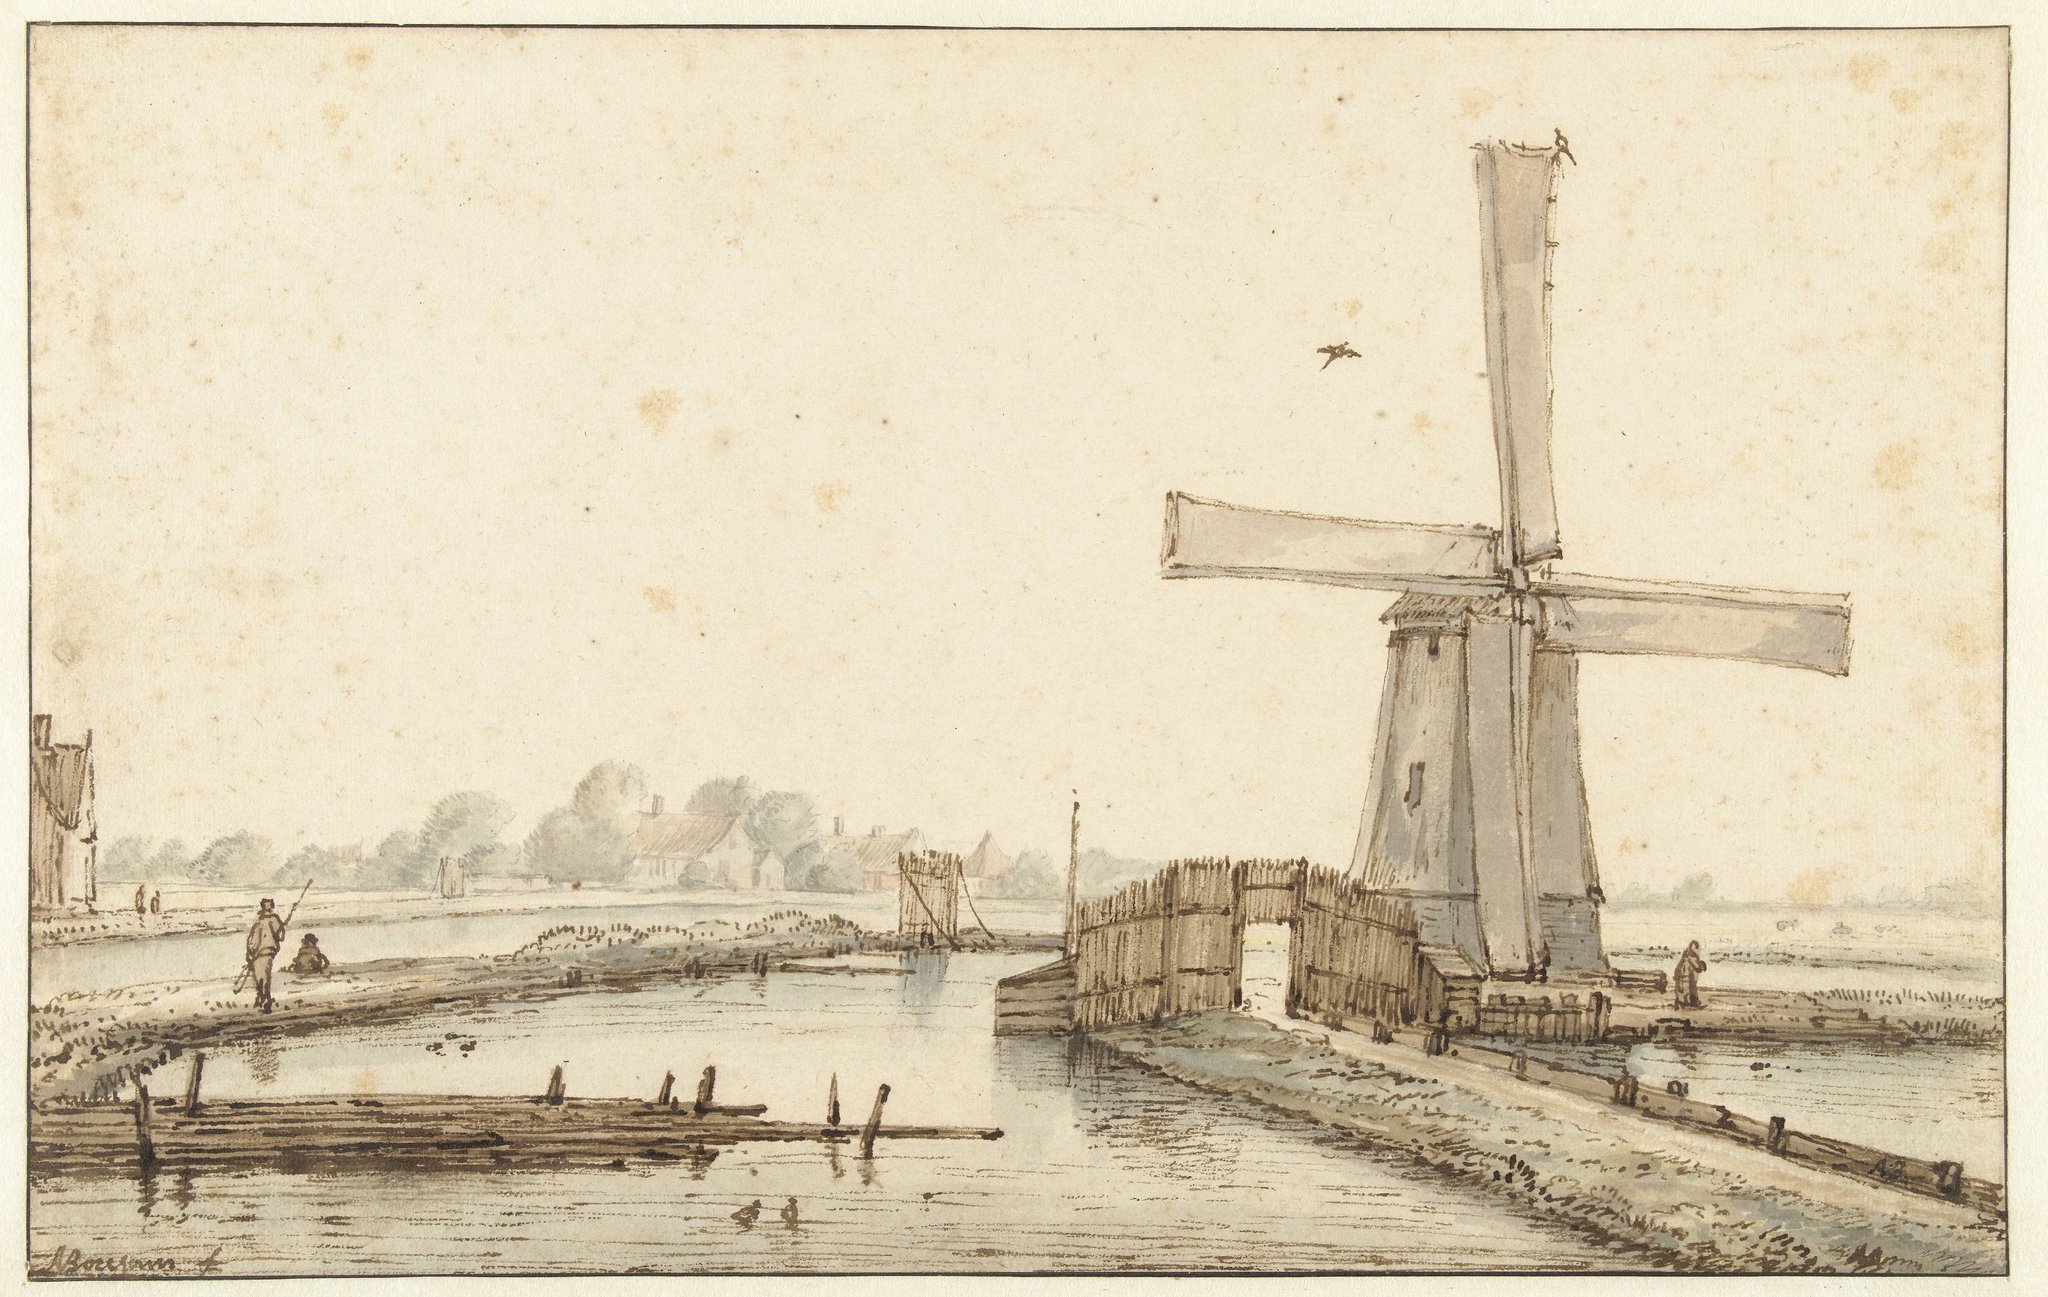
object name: drawing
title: De windmolen aan het water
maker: anthonie van borssom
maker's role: draughtsman, print maker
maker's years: 1629-1677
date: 1660-1677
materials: ink, paper, watercolor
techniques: brush, pen